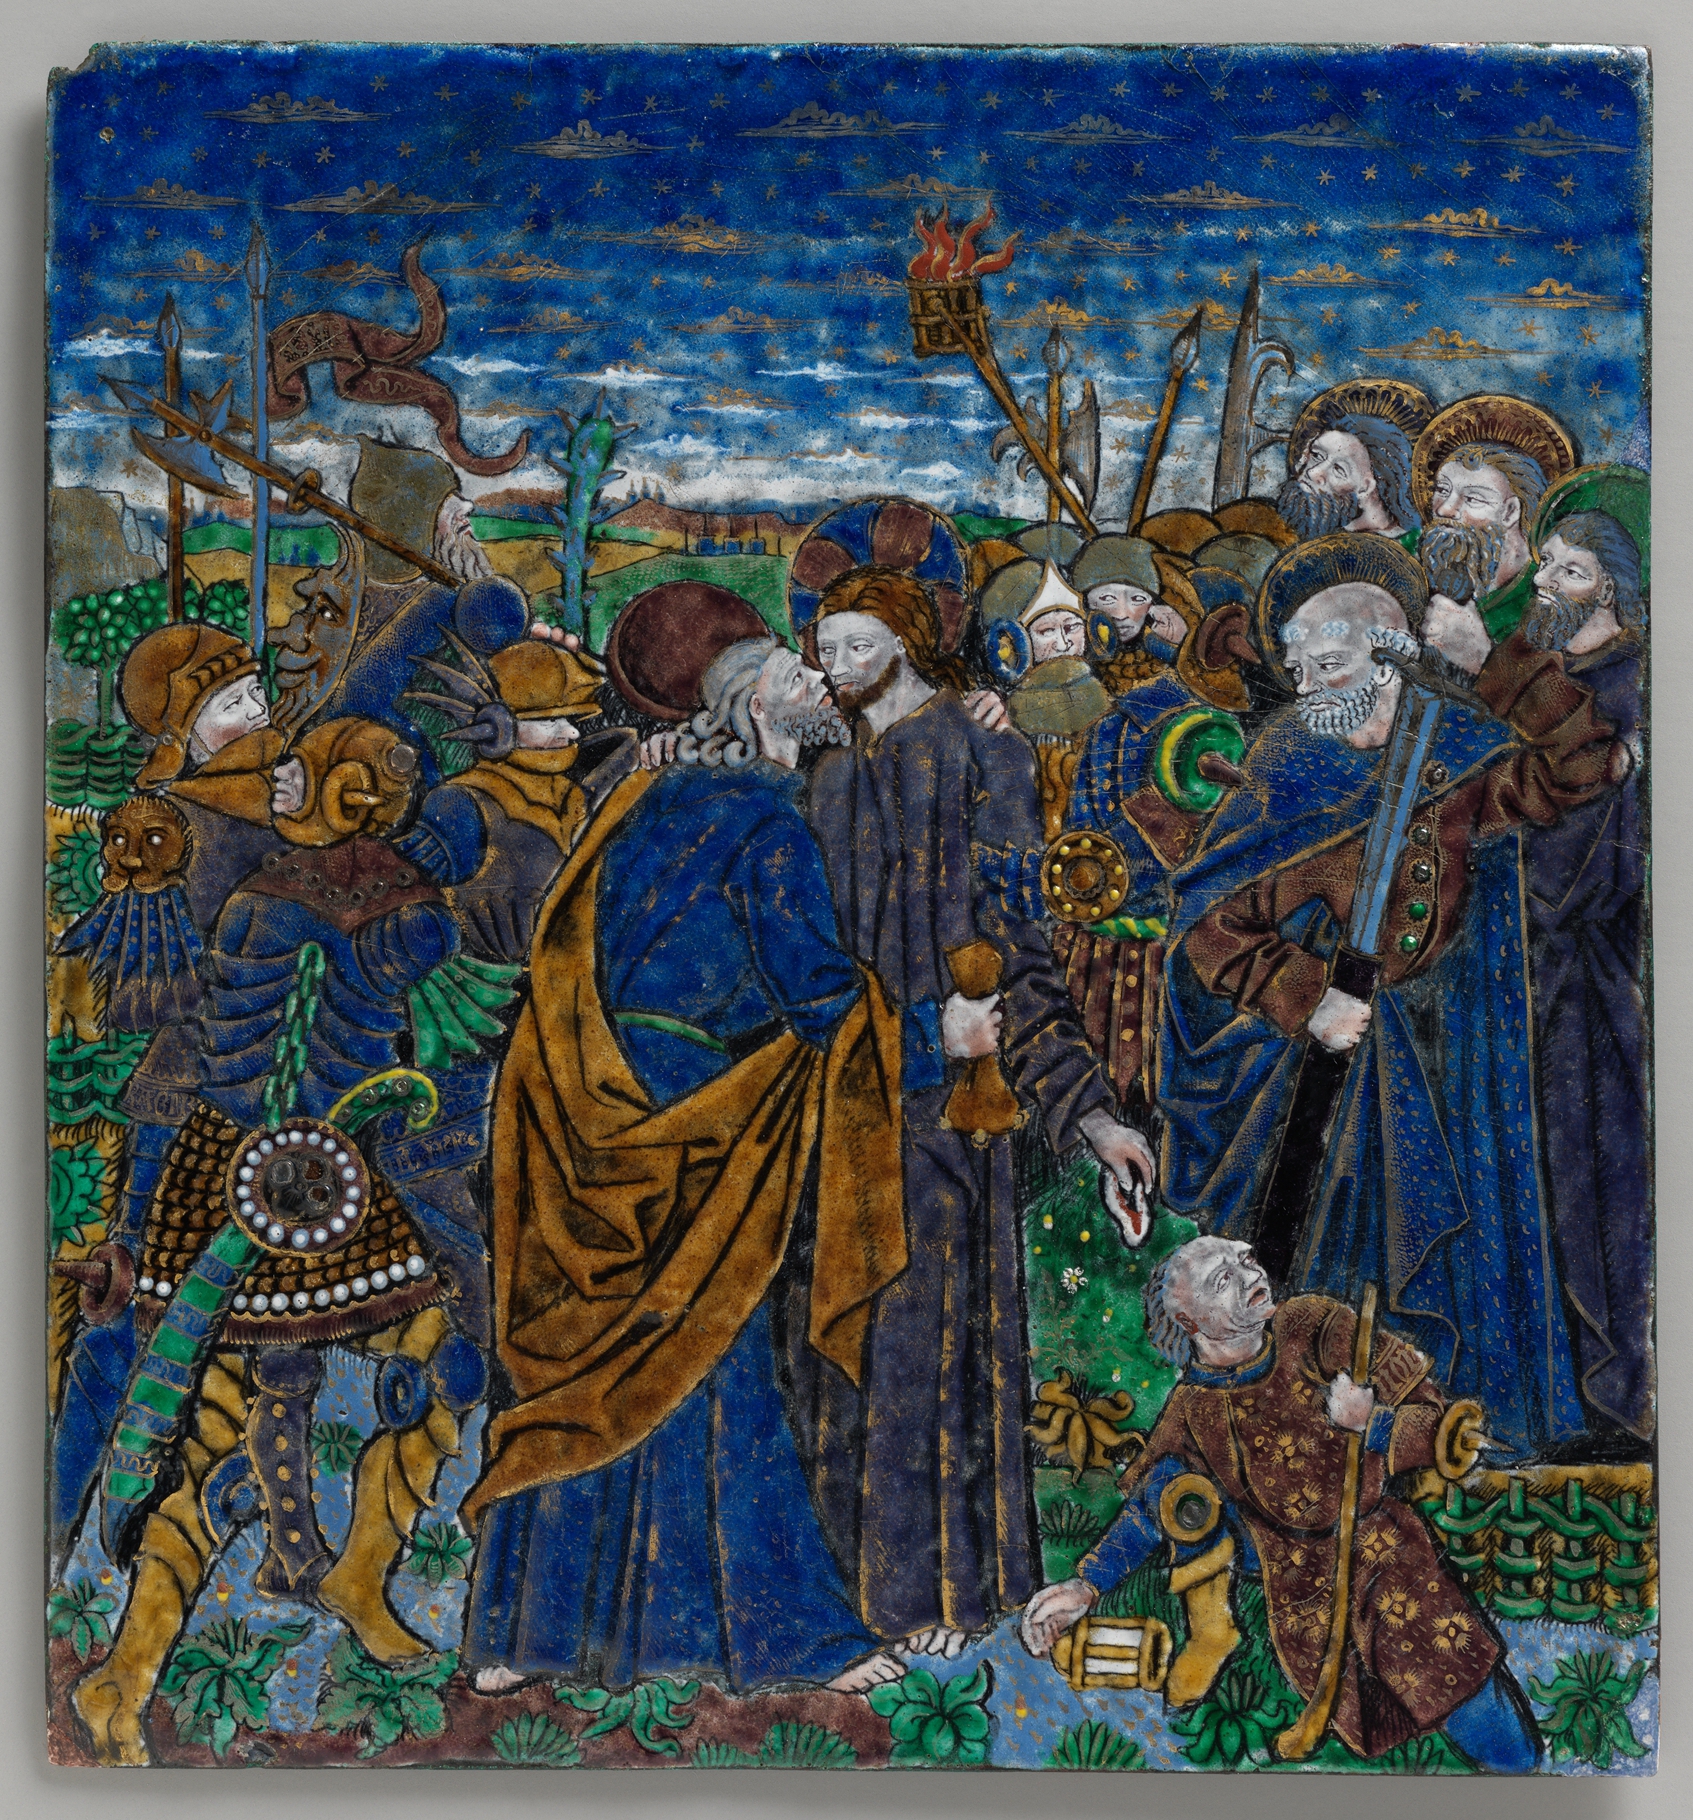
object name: plaque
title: Plaque with The Betrayal of Christ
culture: french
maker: monvaerni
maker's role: artist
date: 1401-1500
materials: copper, enamel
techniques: painting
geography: france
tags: men,christ